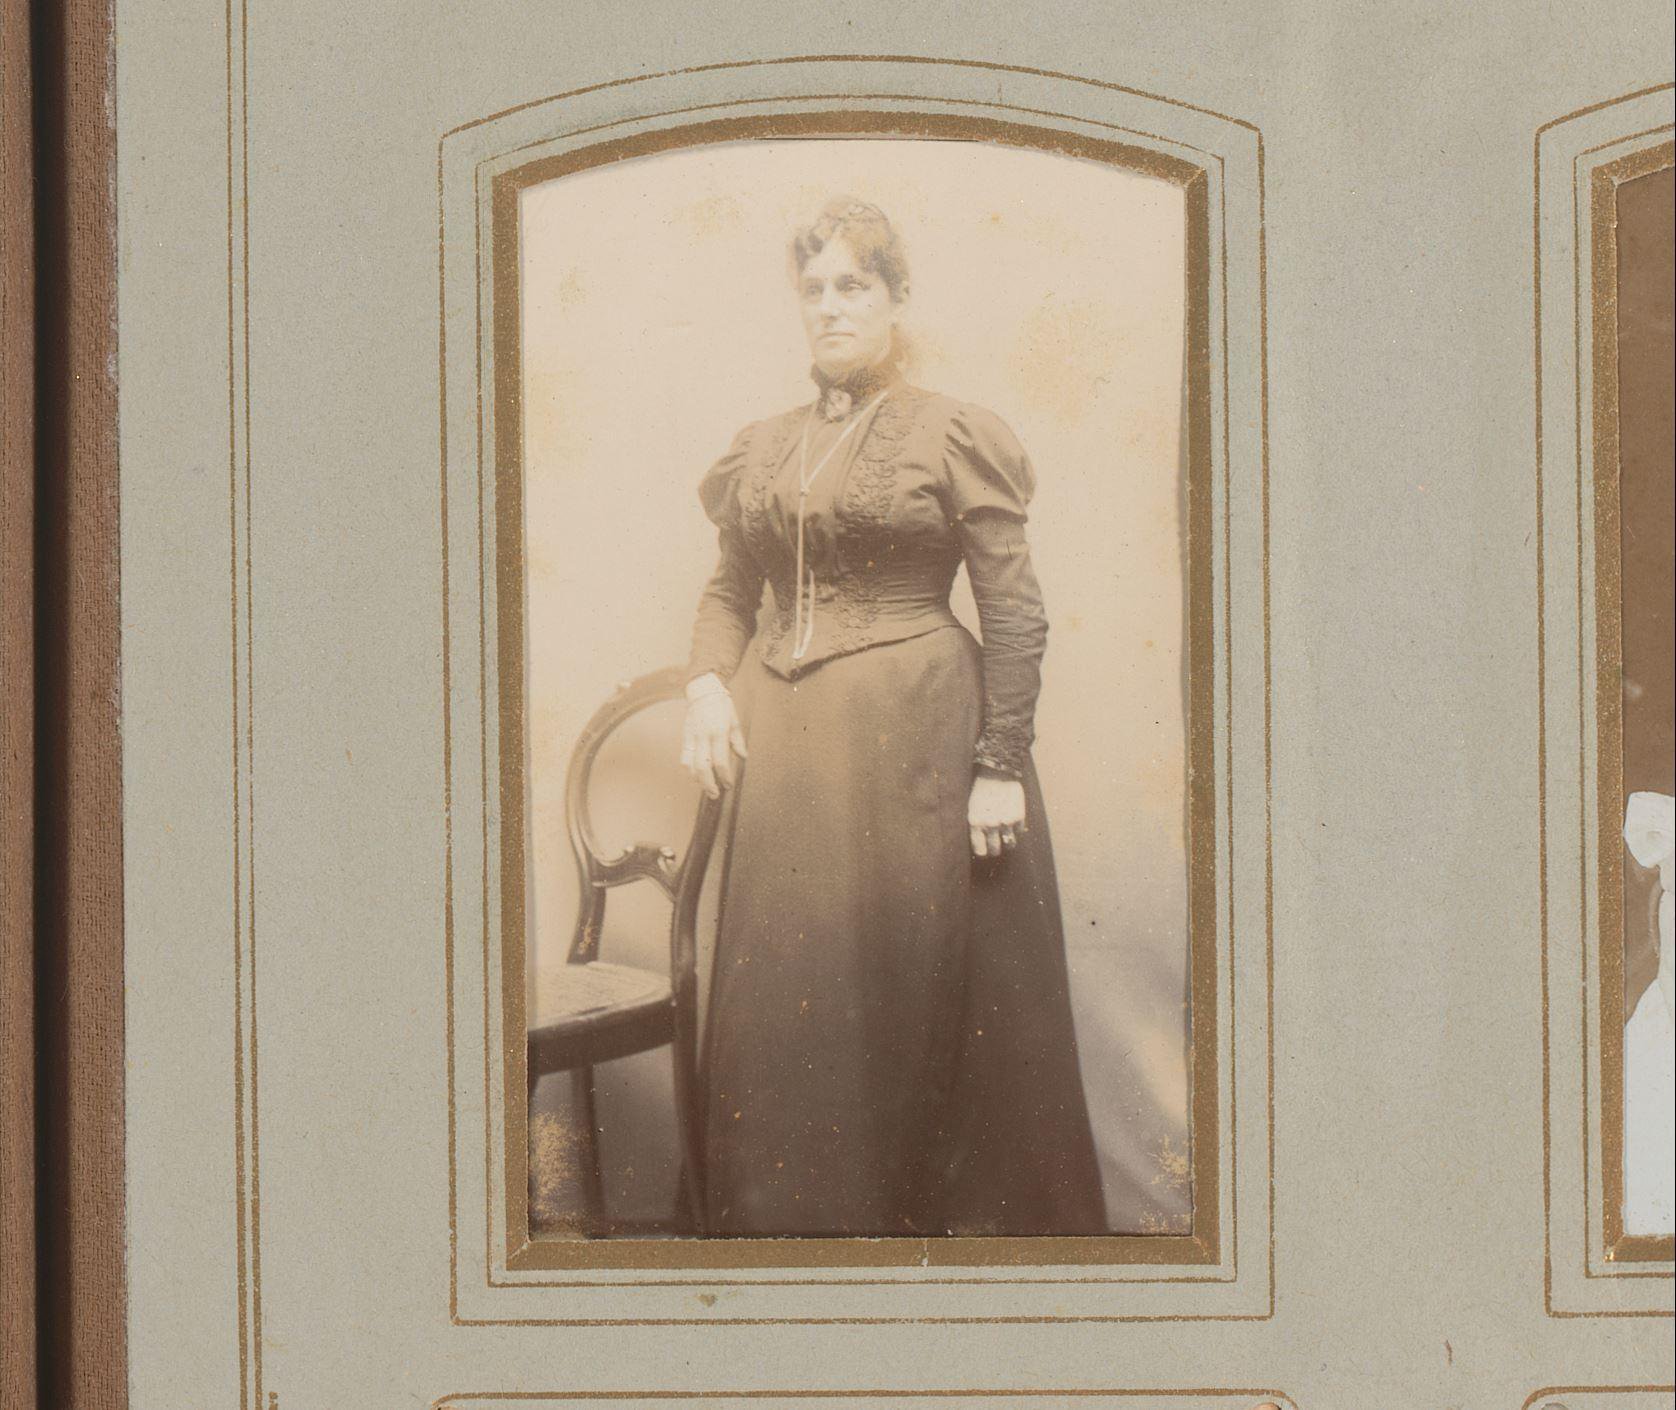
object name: photograph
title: Portret van een vrouw, staand bij een stoel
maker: Anonymous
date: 1882-1920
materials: cardboard, photographic support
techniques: gelatin silver print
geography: netherlands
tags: historical persons - bb - woman, chair